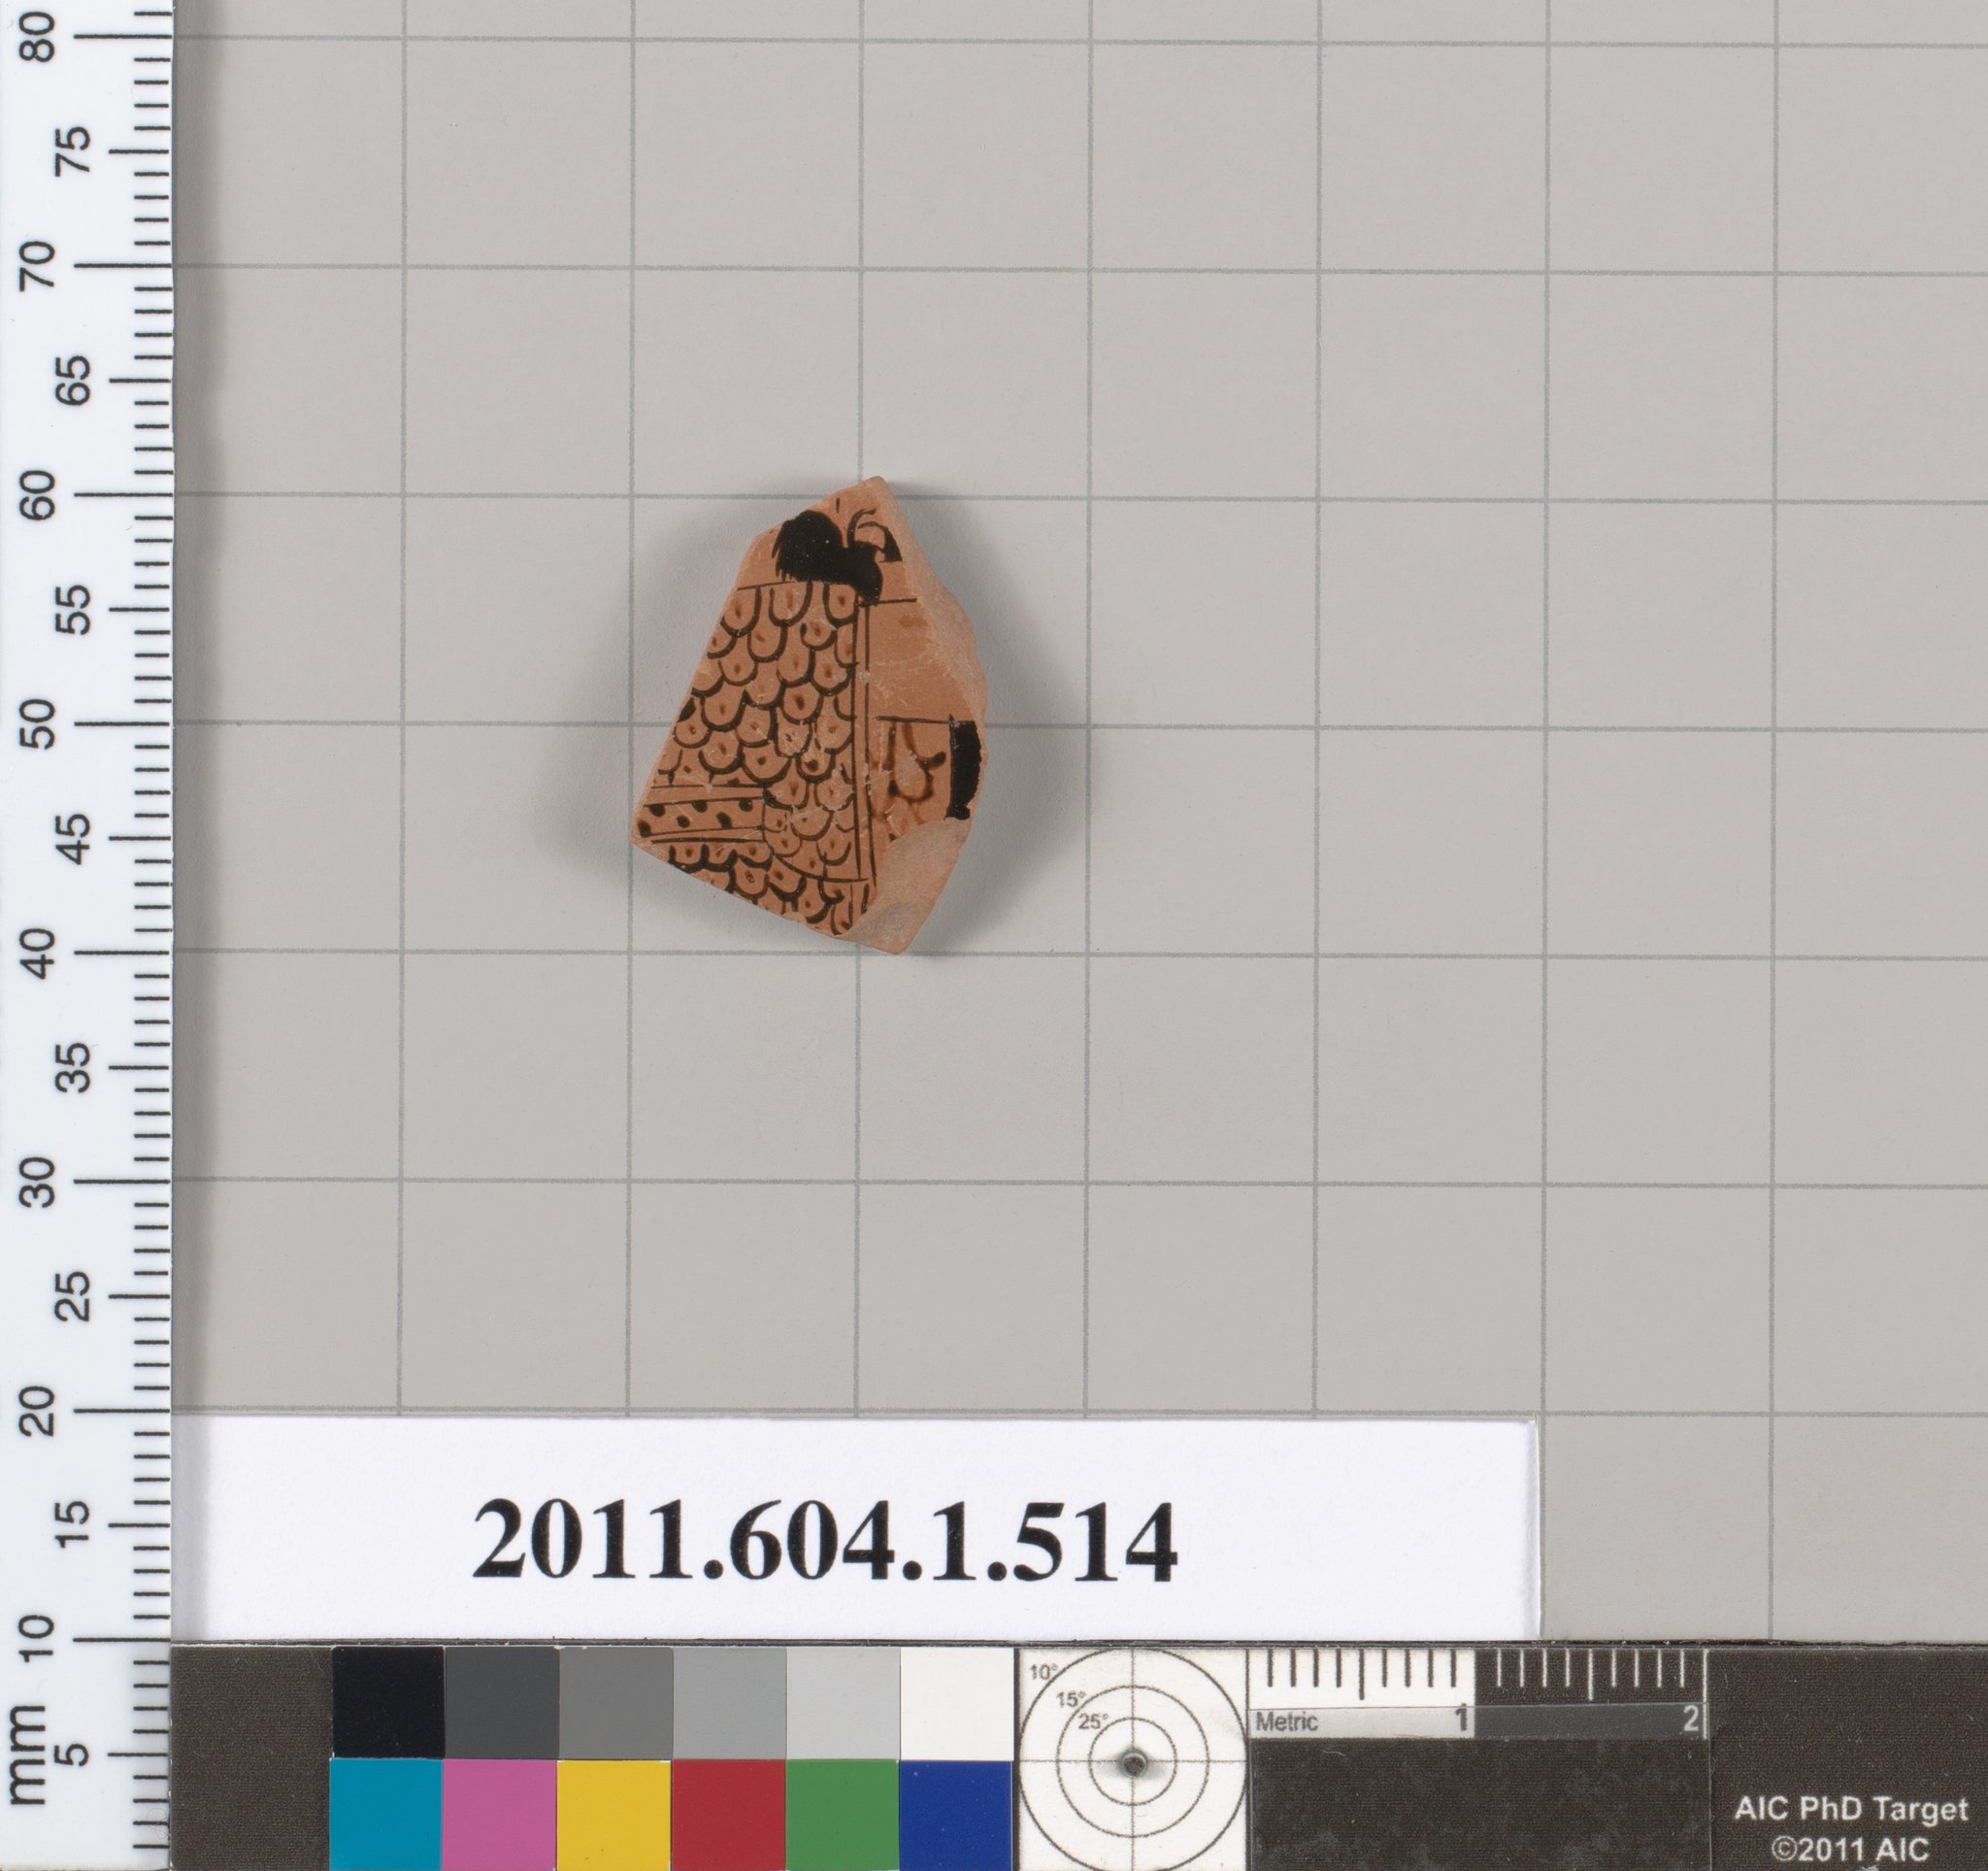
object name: kylix fragment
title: Terracotta fragment of a kylix (drinking cup)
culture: greek, attic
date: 500-476 BCE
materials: terracotta